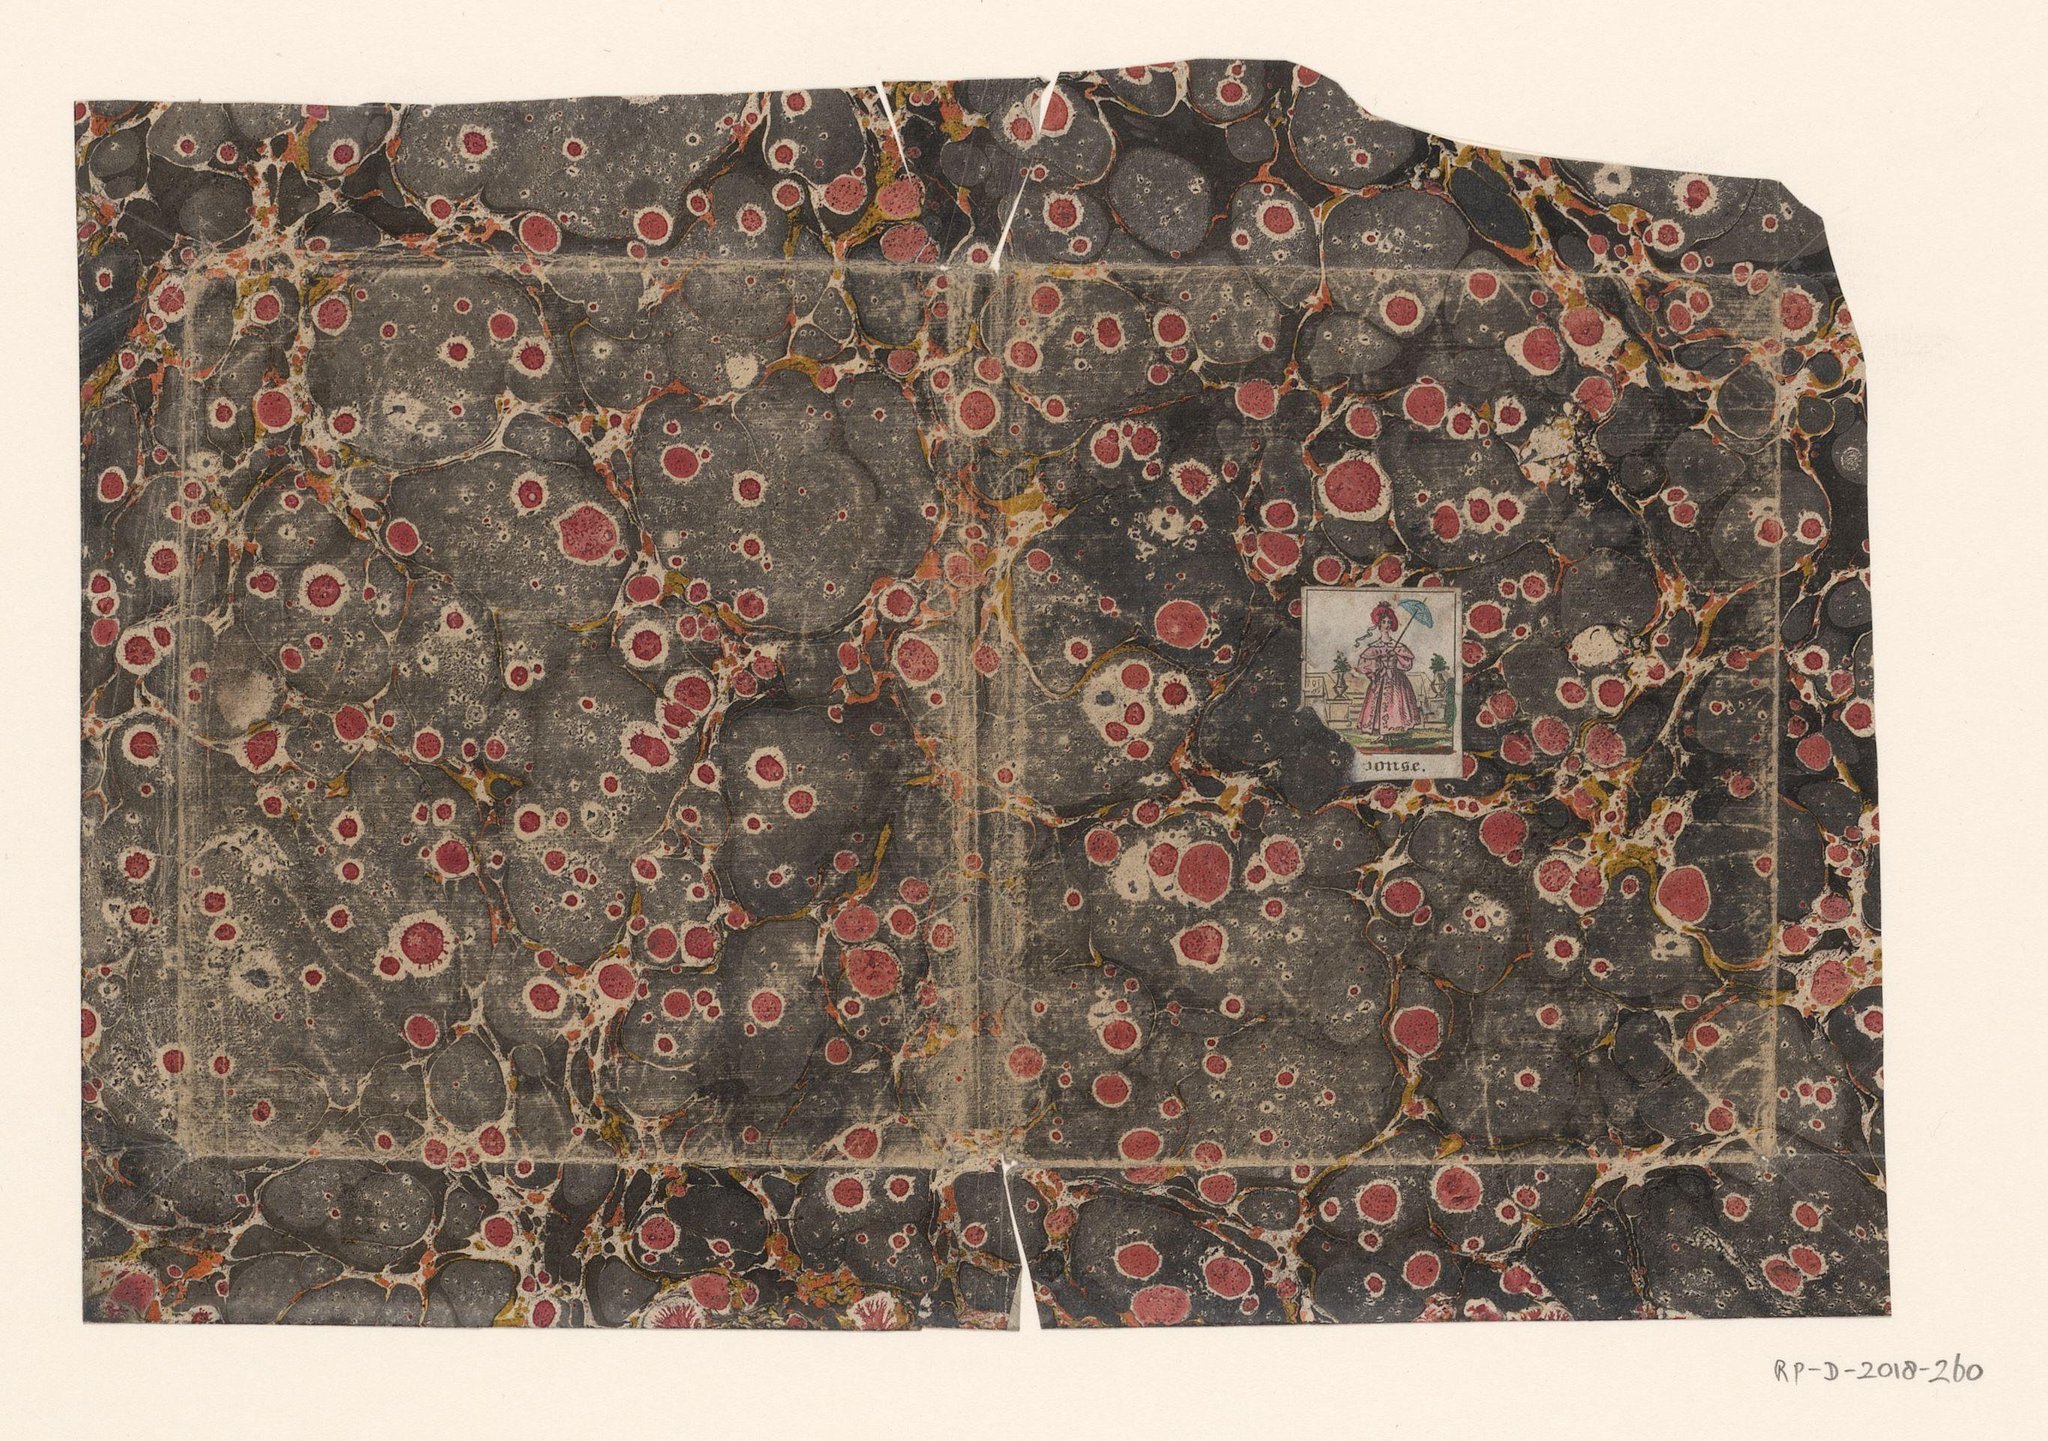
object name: wrapper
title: Kiezelmarmer in rood, zwart en geel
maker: Anonymous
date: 1750-1900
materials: lacquer, paint, paper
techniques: lacquer, marbling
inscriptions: collector's mark: Lugt 2228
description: Kiezelmarmer in rood, zwart en geel. Gebruikt als omslag, met insnijdingen bij de rug. Met opgeplakte etiket met afbeelding van staande jonge vrouw, met opschrift '... onse'.